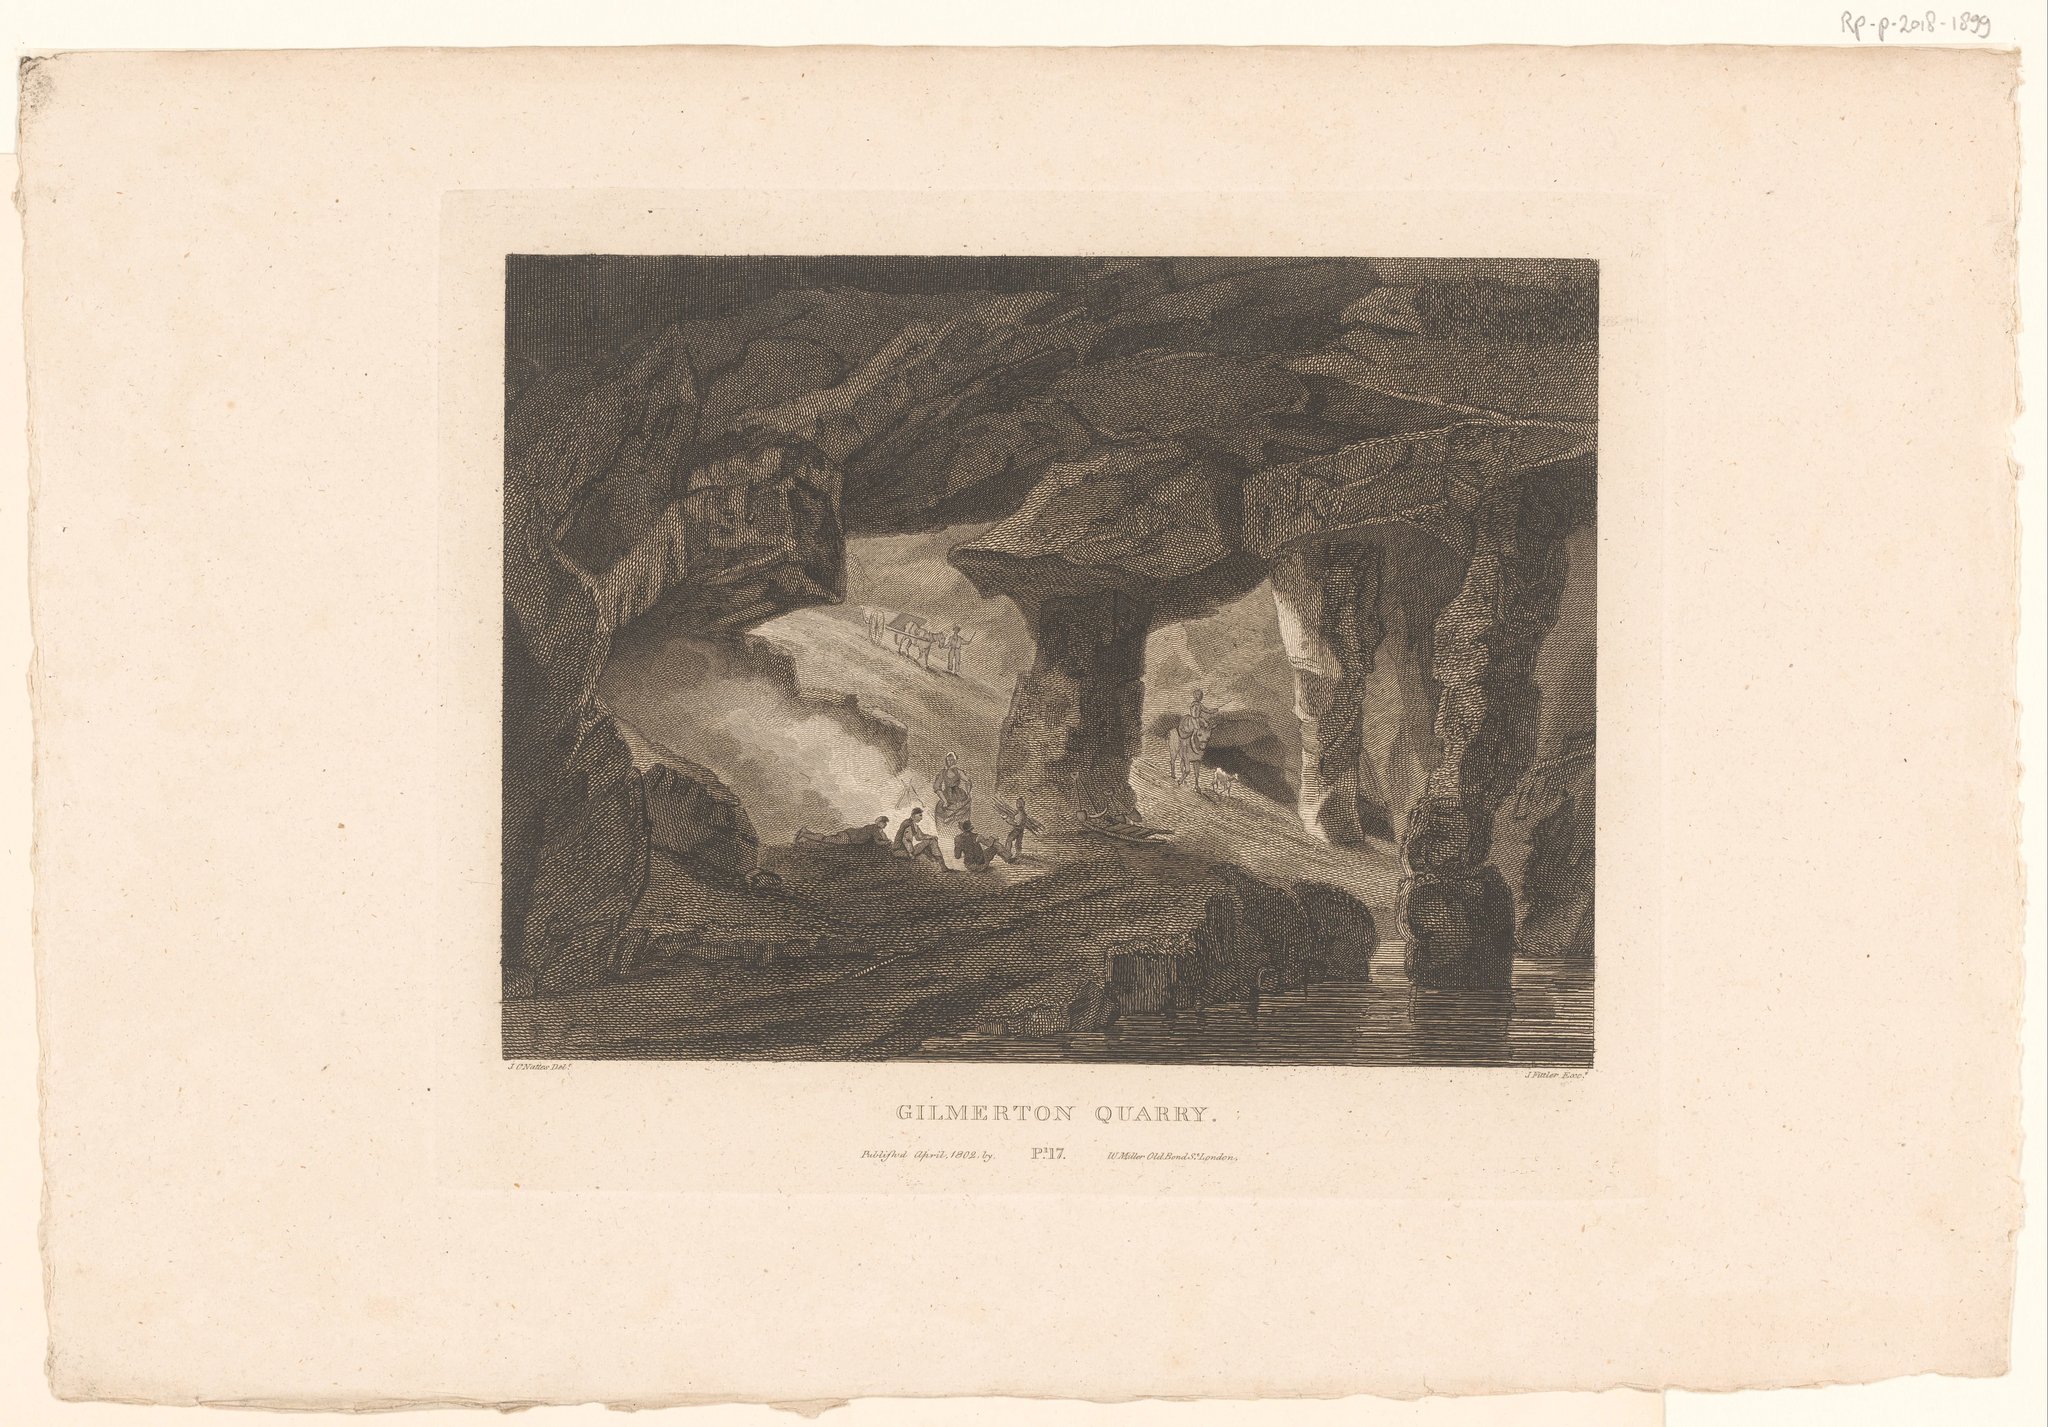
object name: print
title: Gezicht op groeve van Gilmerton, bij Edinburgh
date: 1801-1802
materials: paper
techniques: engraving, etching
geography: london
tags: quarry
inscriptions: collector's mark: Lugt 2228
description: Prent gebruikt in: Scotia Depicta; or the antiquities, castles, public buildings, noblemen (...). Londen: William Miller, 1801. Zie ook: RP-P-2018-1929.